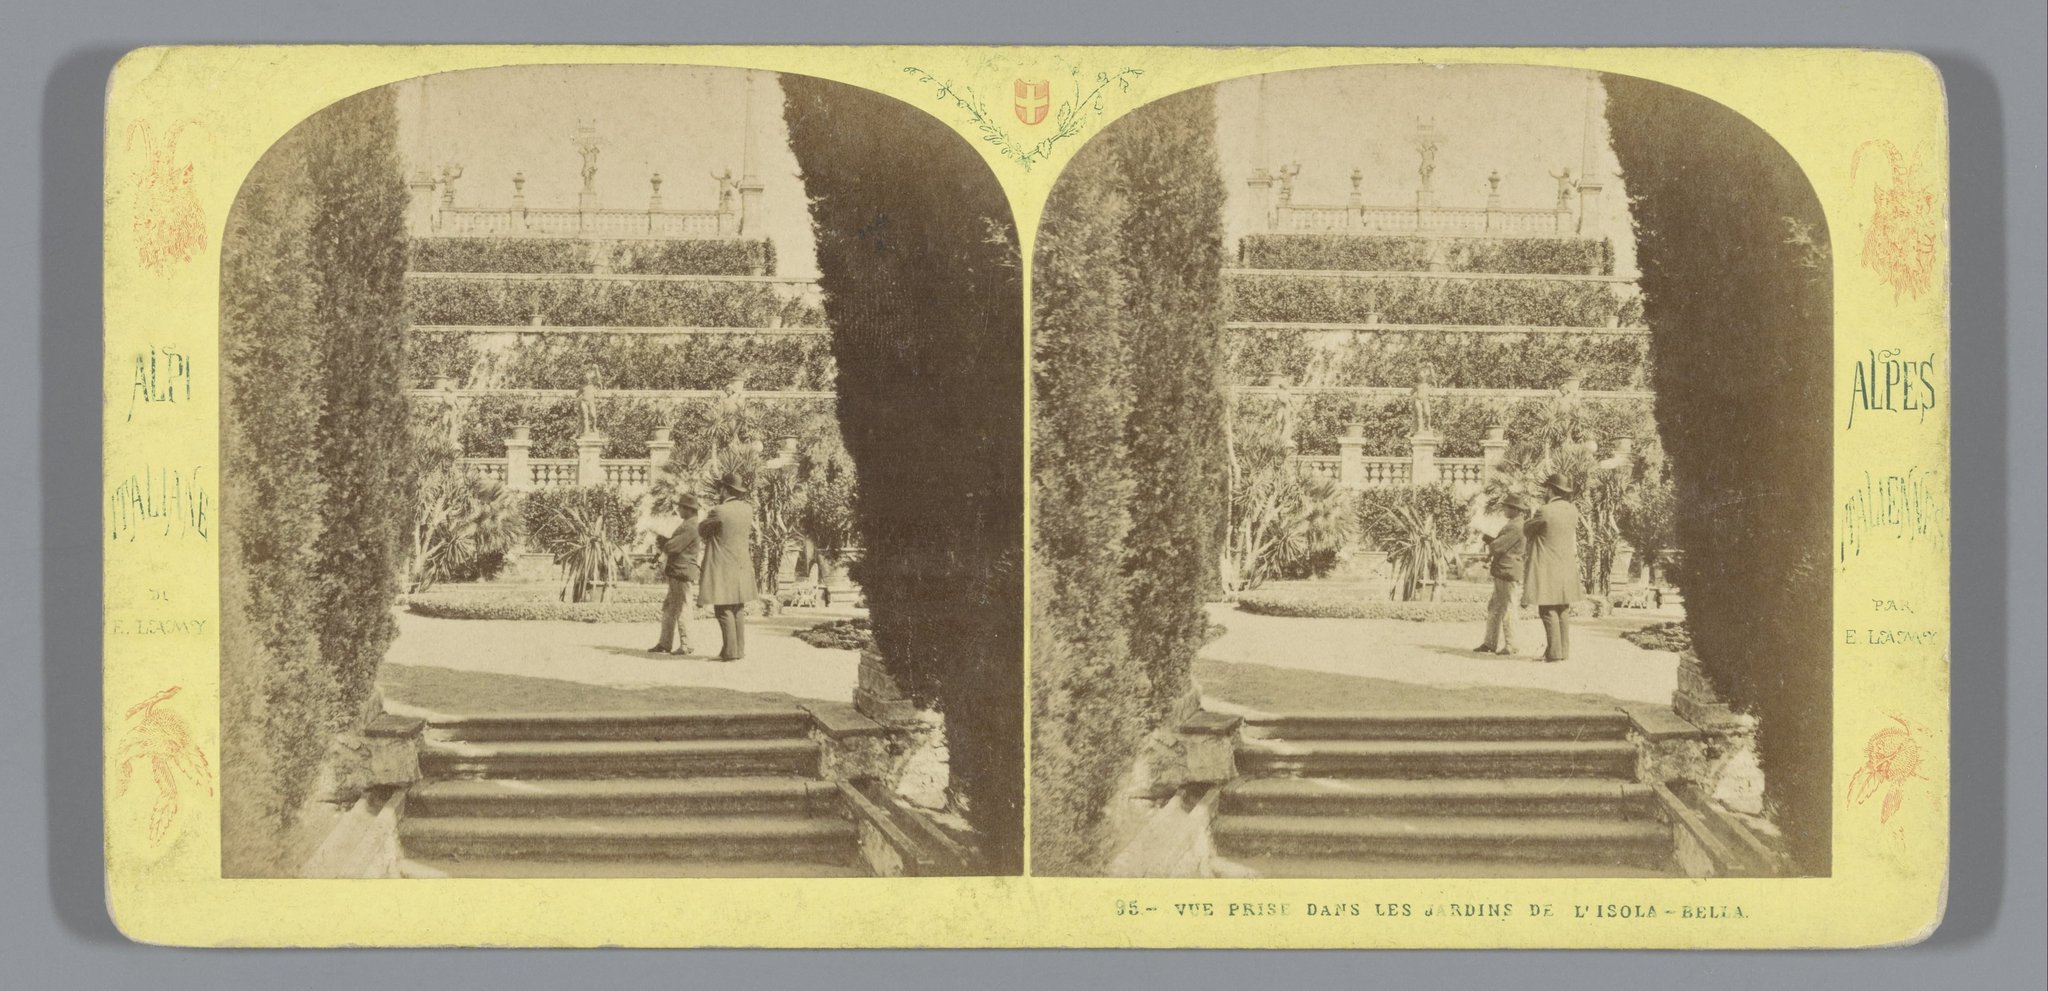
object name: stereograph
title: Tuin van Palazzo Borromeo op Isola Bella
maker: ernest eléonor pierre lamy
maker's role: publisher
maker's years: 1828-1900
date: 1861-1878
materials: cardboard, paper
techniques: albumen print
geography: isola bella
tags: french or architectonic garden; formal garden, statues, sculptures in garden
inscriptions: number: ‘95.’